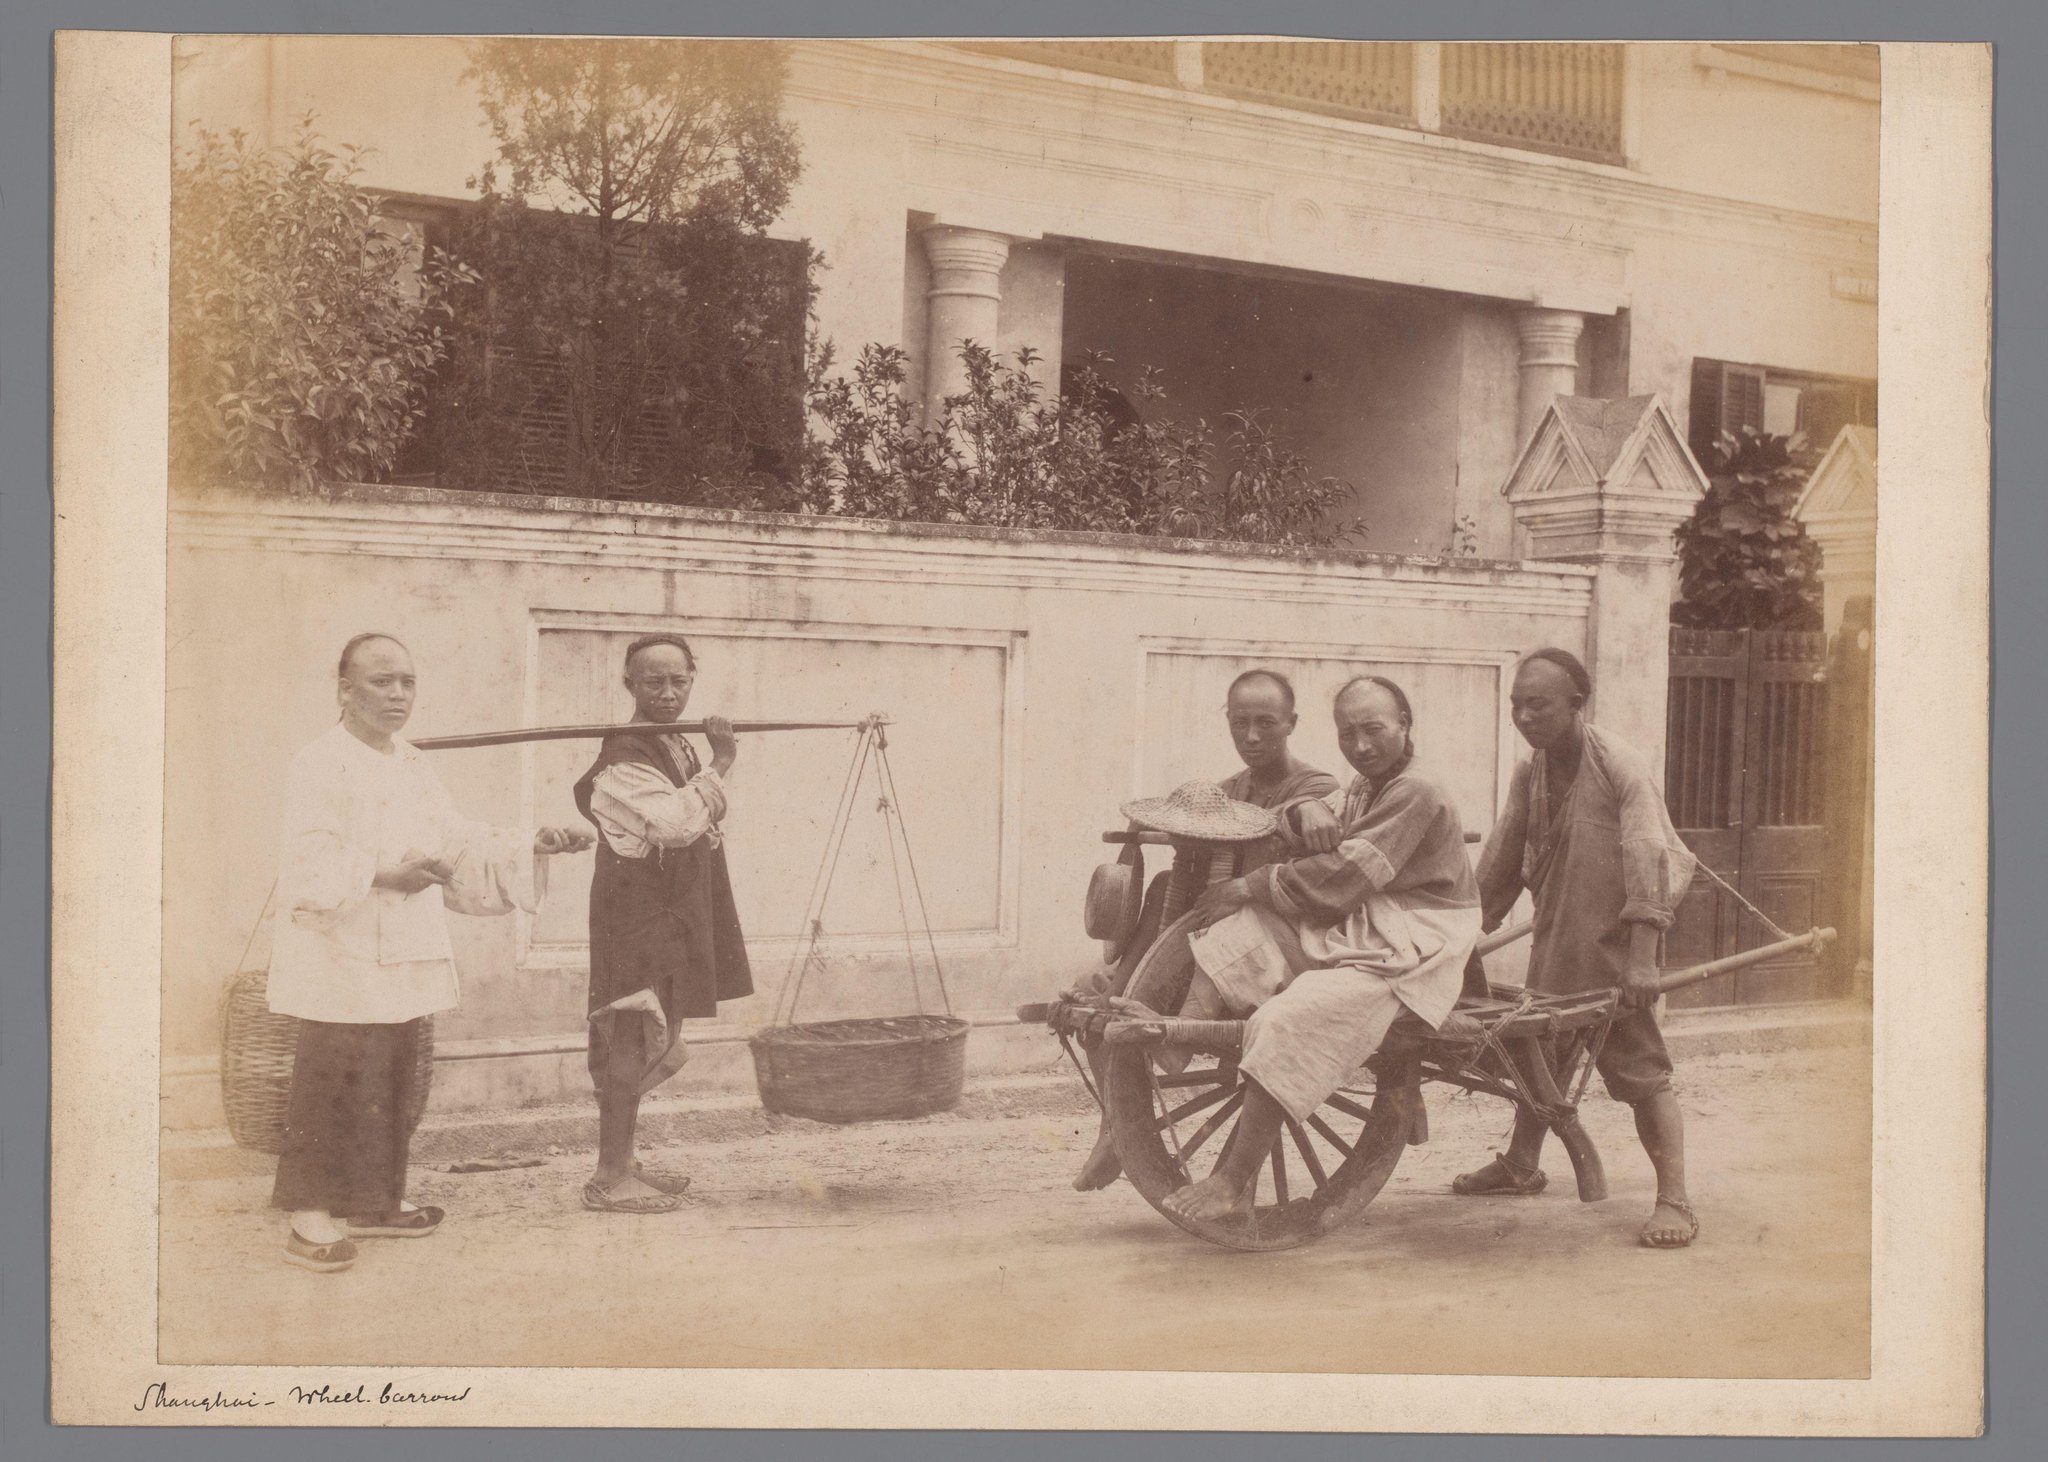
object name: photograph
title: Vijf mannen met kruiwagen en draagstok te Shanghai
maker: Anonymous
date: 1850-1900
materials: cardboard, photographic support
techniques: albumen print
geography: shanghai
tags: carrying something with carrying-pole, wheelbarrow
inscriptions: annotation: ‘Shanghai-Wheel barrow’